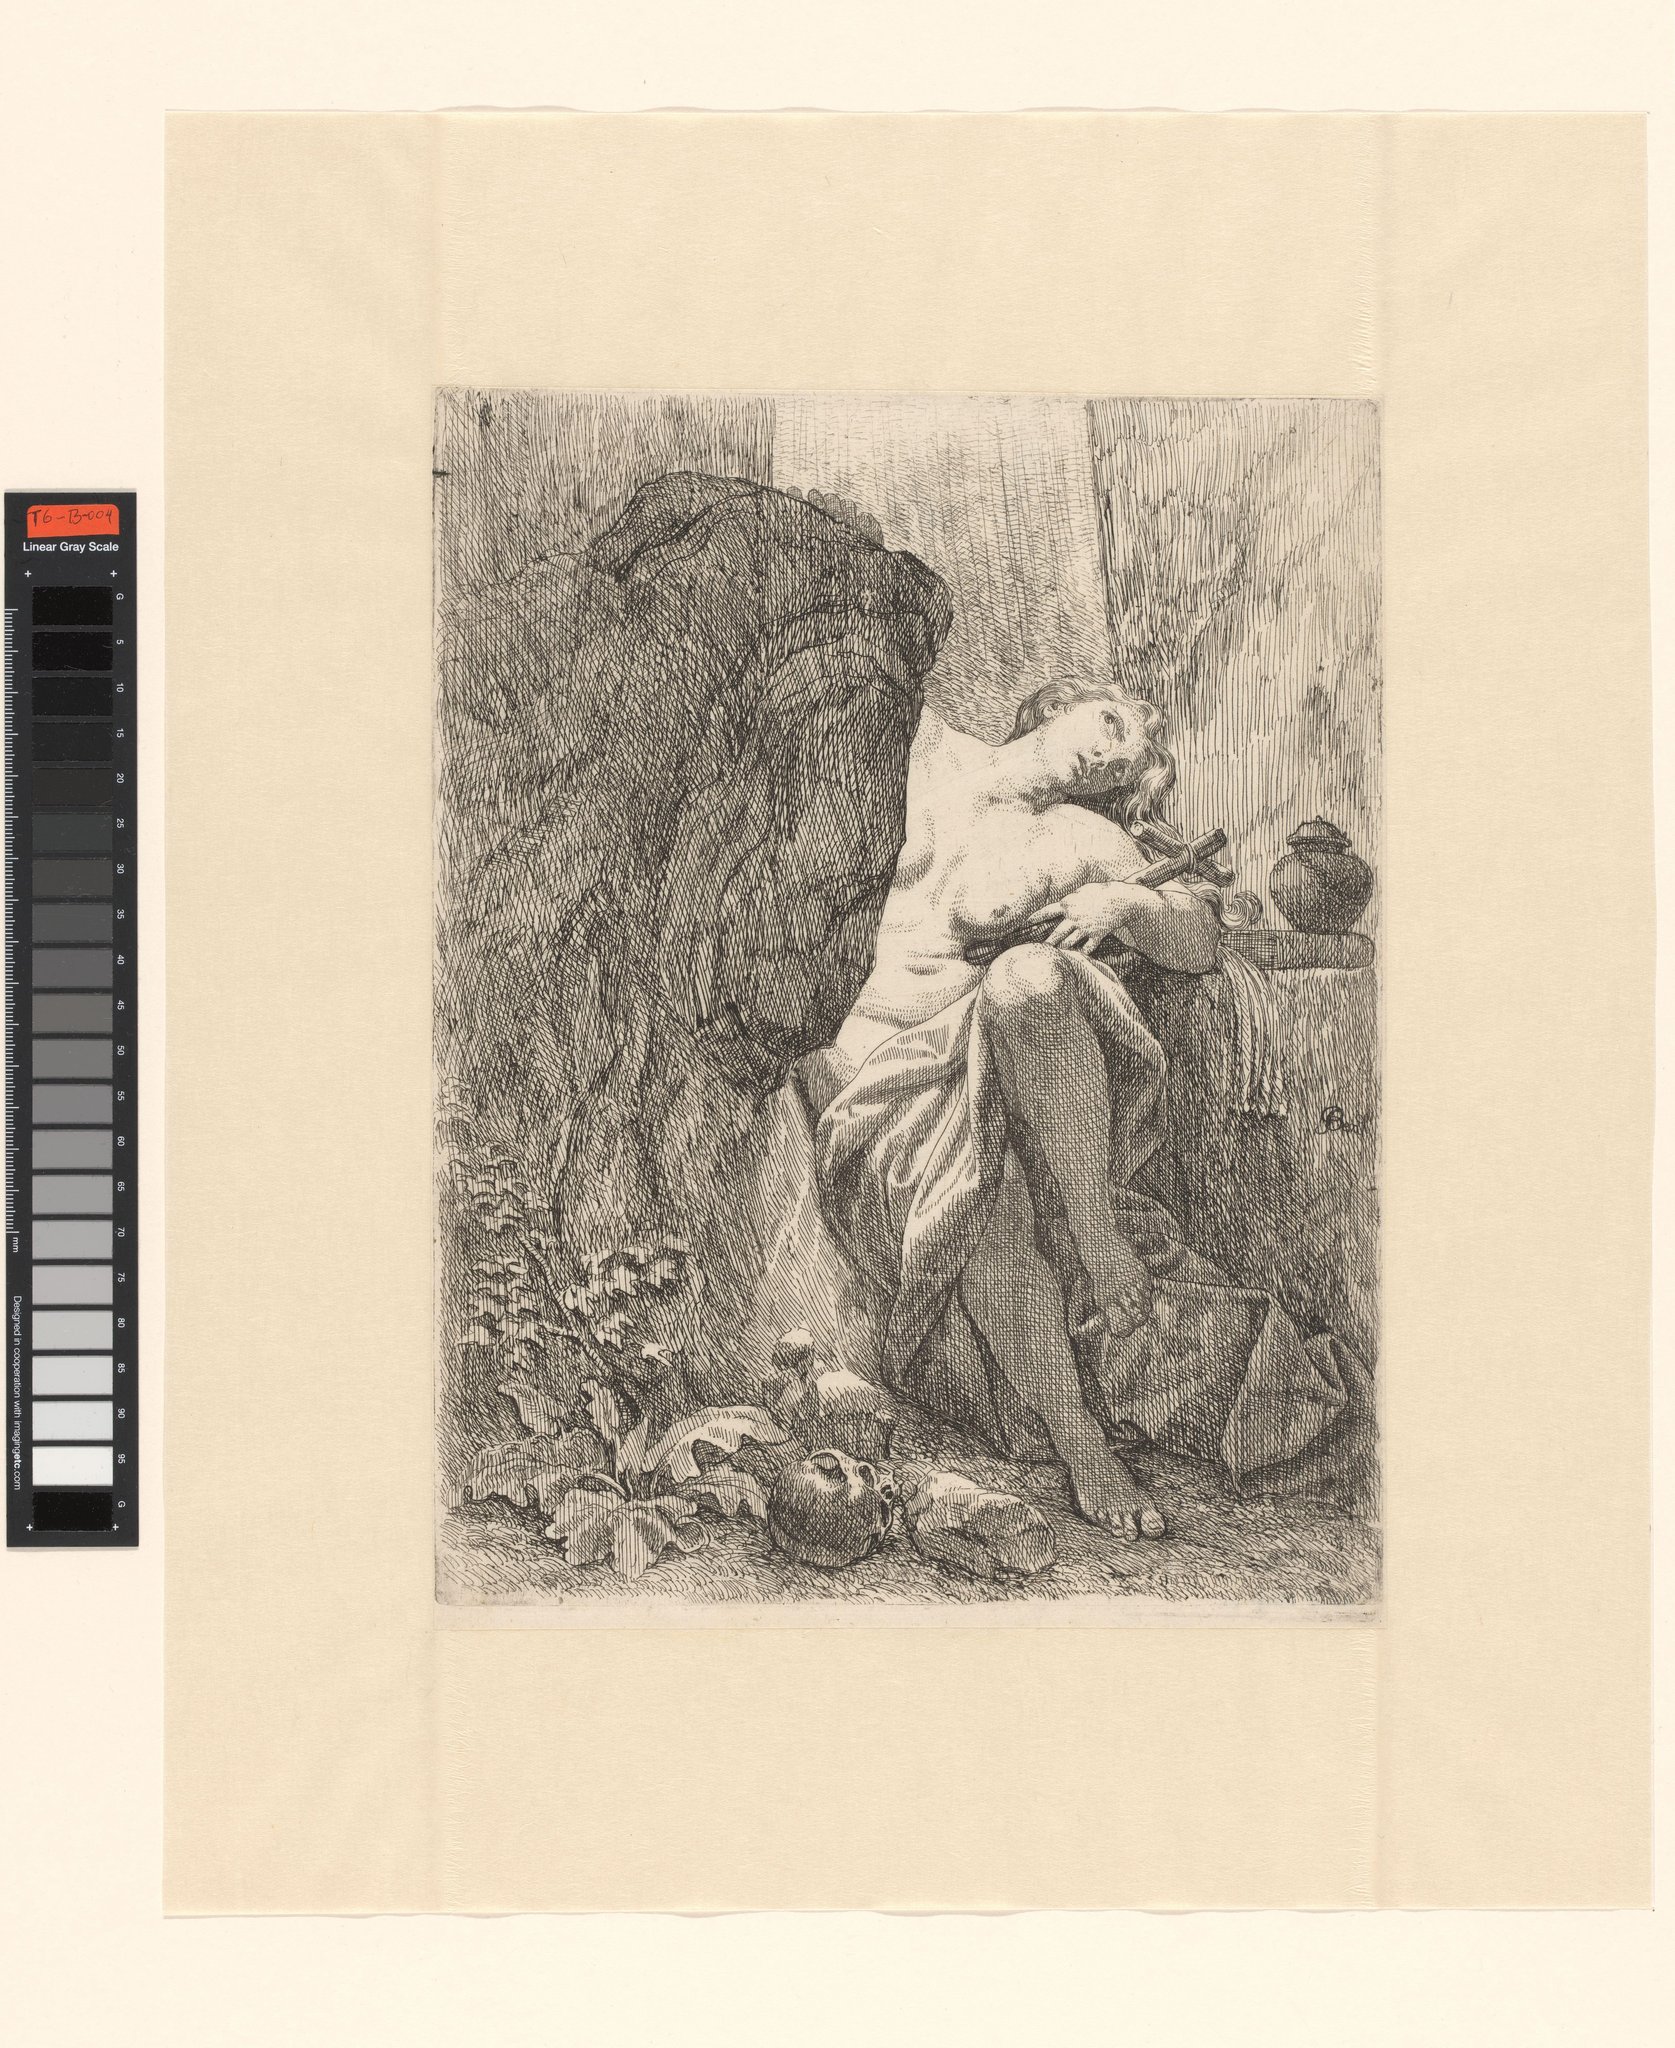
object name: print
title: De boetvaardige Maria Magdalena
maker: ignaz bendl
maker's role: print maker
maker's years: 1680-1730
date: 1700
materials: paper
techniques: etching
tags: the penitent st. mary magdalene (often before a cave, possibly at la sainte-baume hill): her long hair covers her (naked) body, she reads, meditates or raises her tear-filled eyes towards heaven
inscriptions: collector's mark: Lugt 2228, collector's mark: Lugt 2760